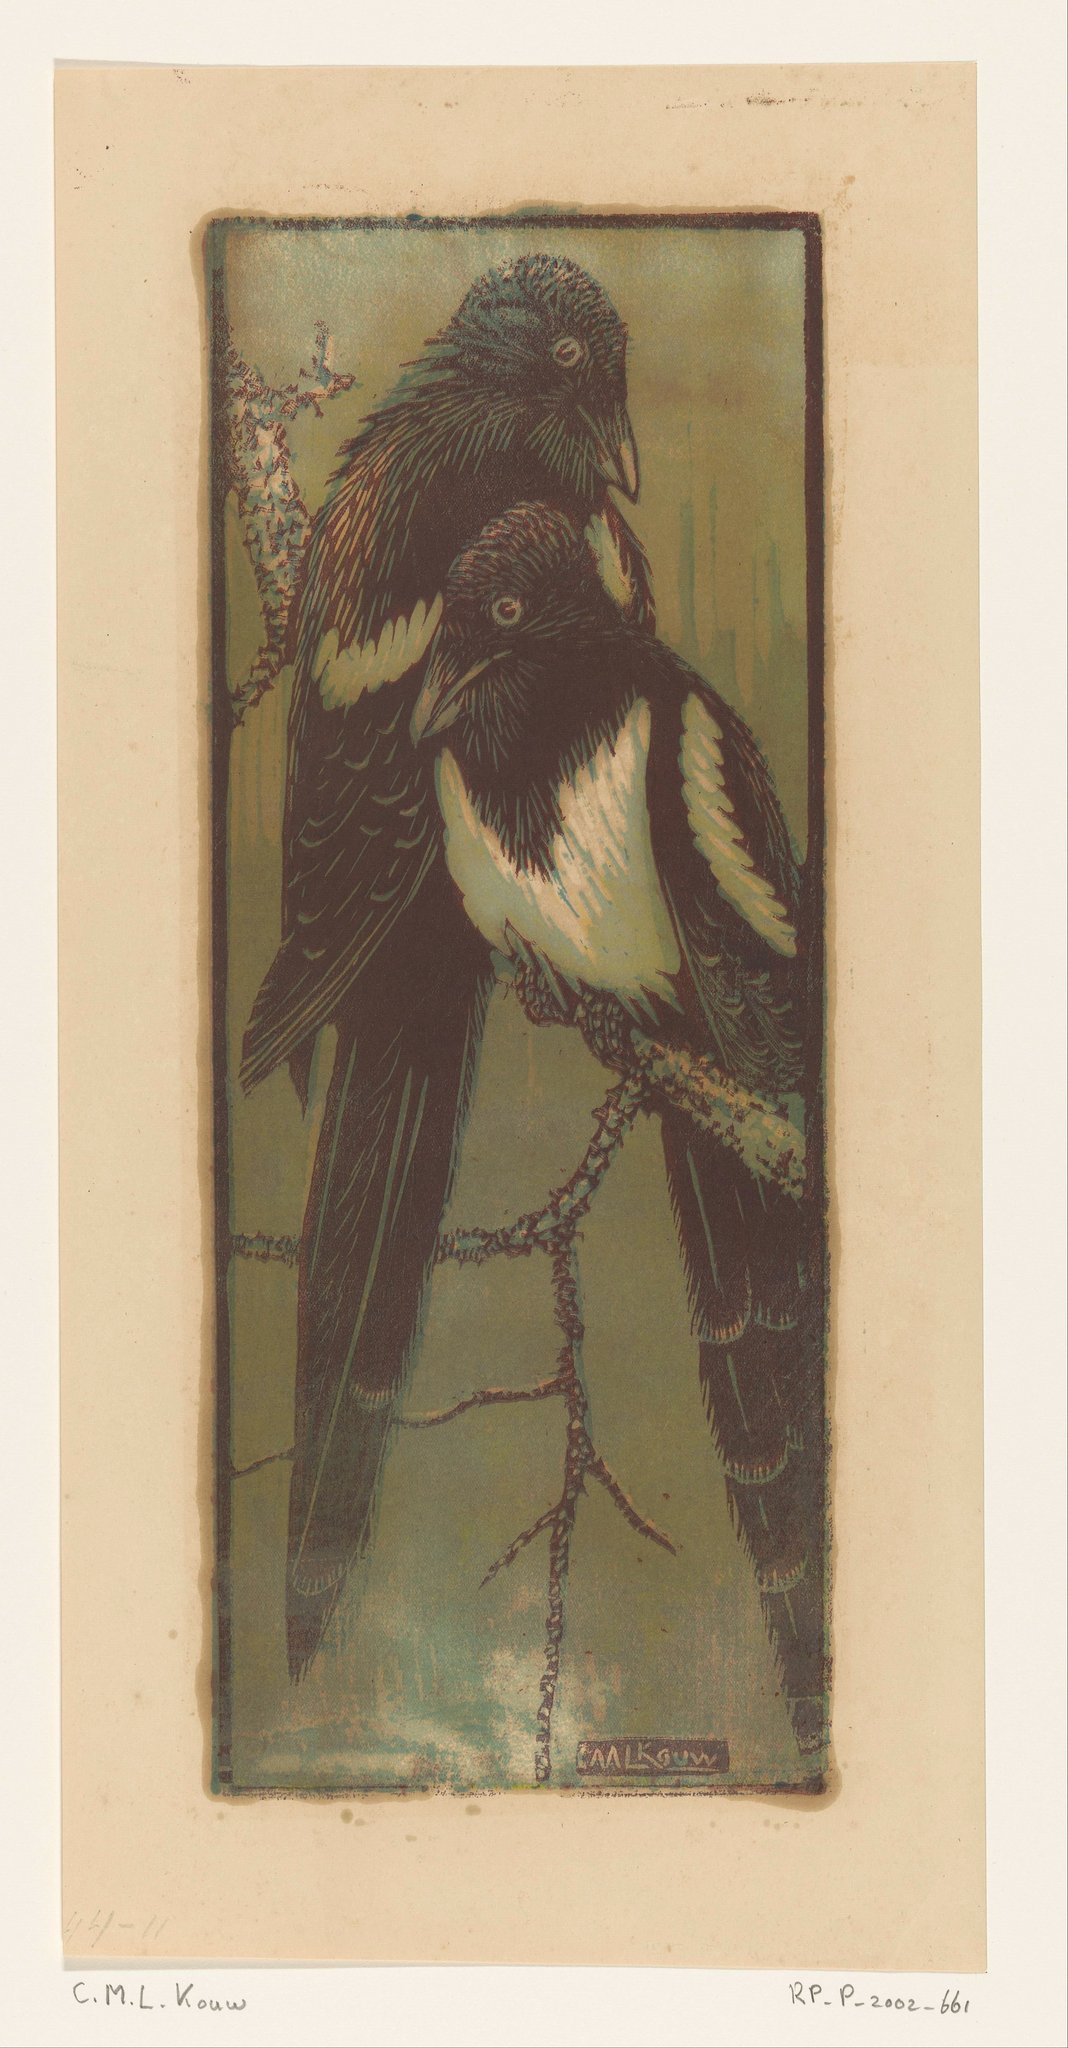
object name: print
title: Twee eksters op een tak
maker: casper m.l. kouw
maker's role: print maker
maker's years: 1865-1939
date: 1875-1939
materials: paper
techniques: woodcut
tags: song-birds: magpie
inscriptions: collector's mark: Lugt 2228